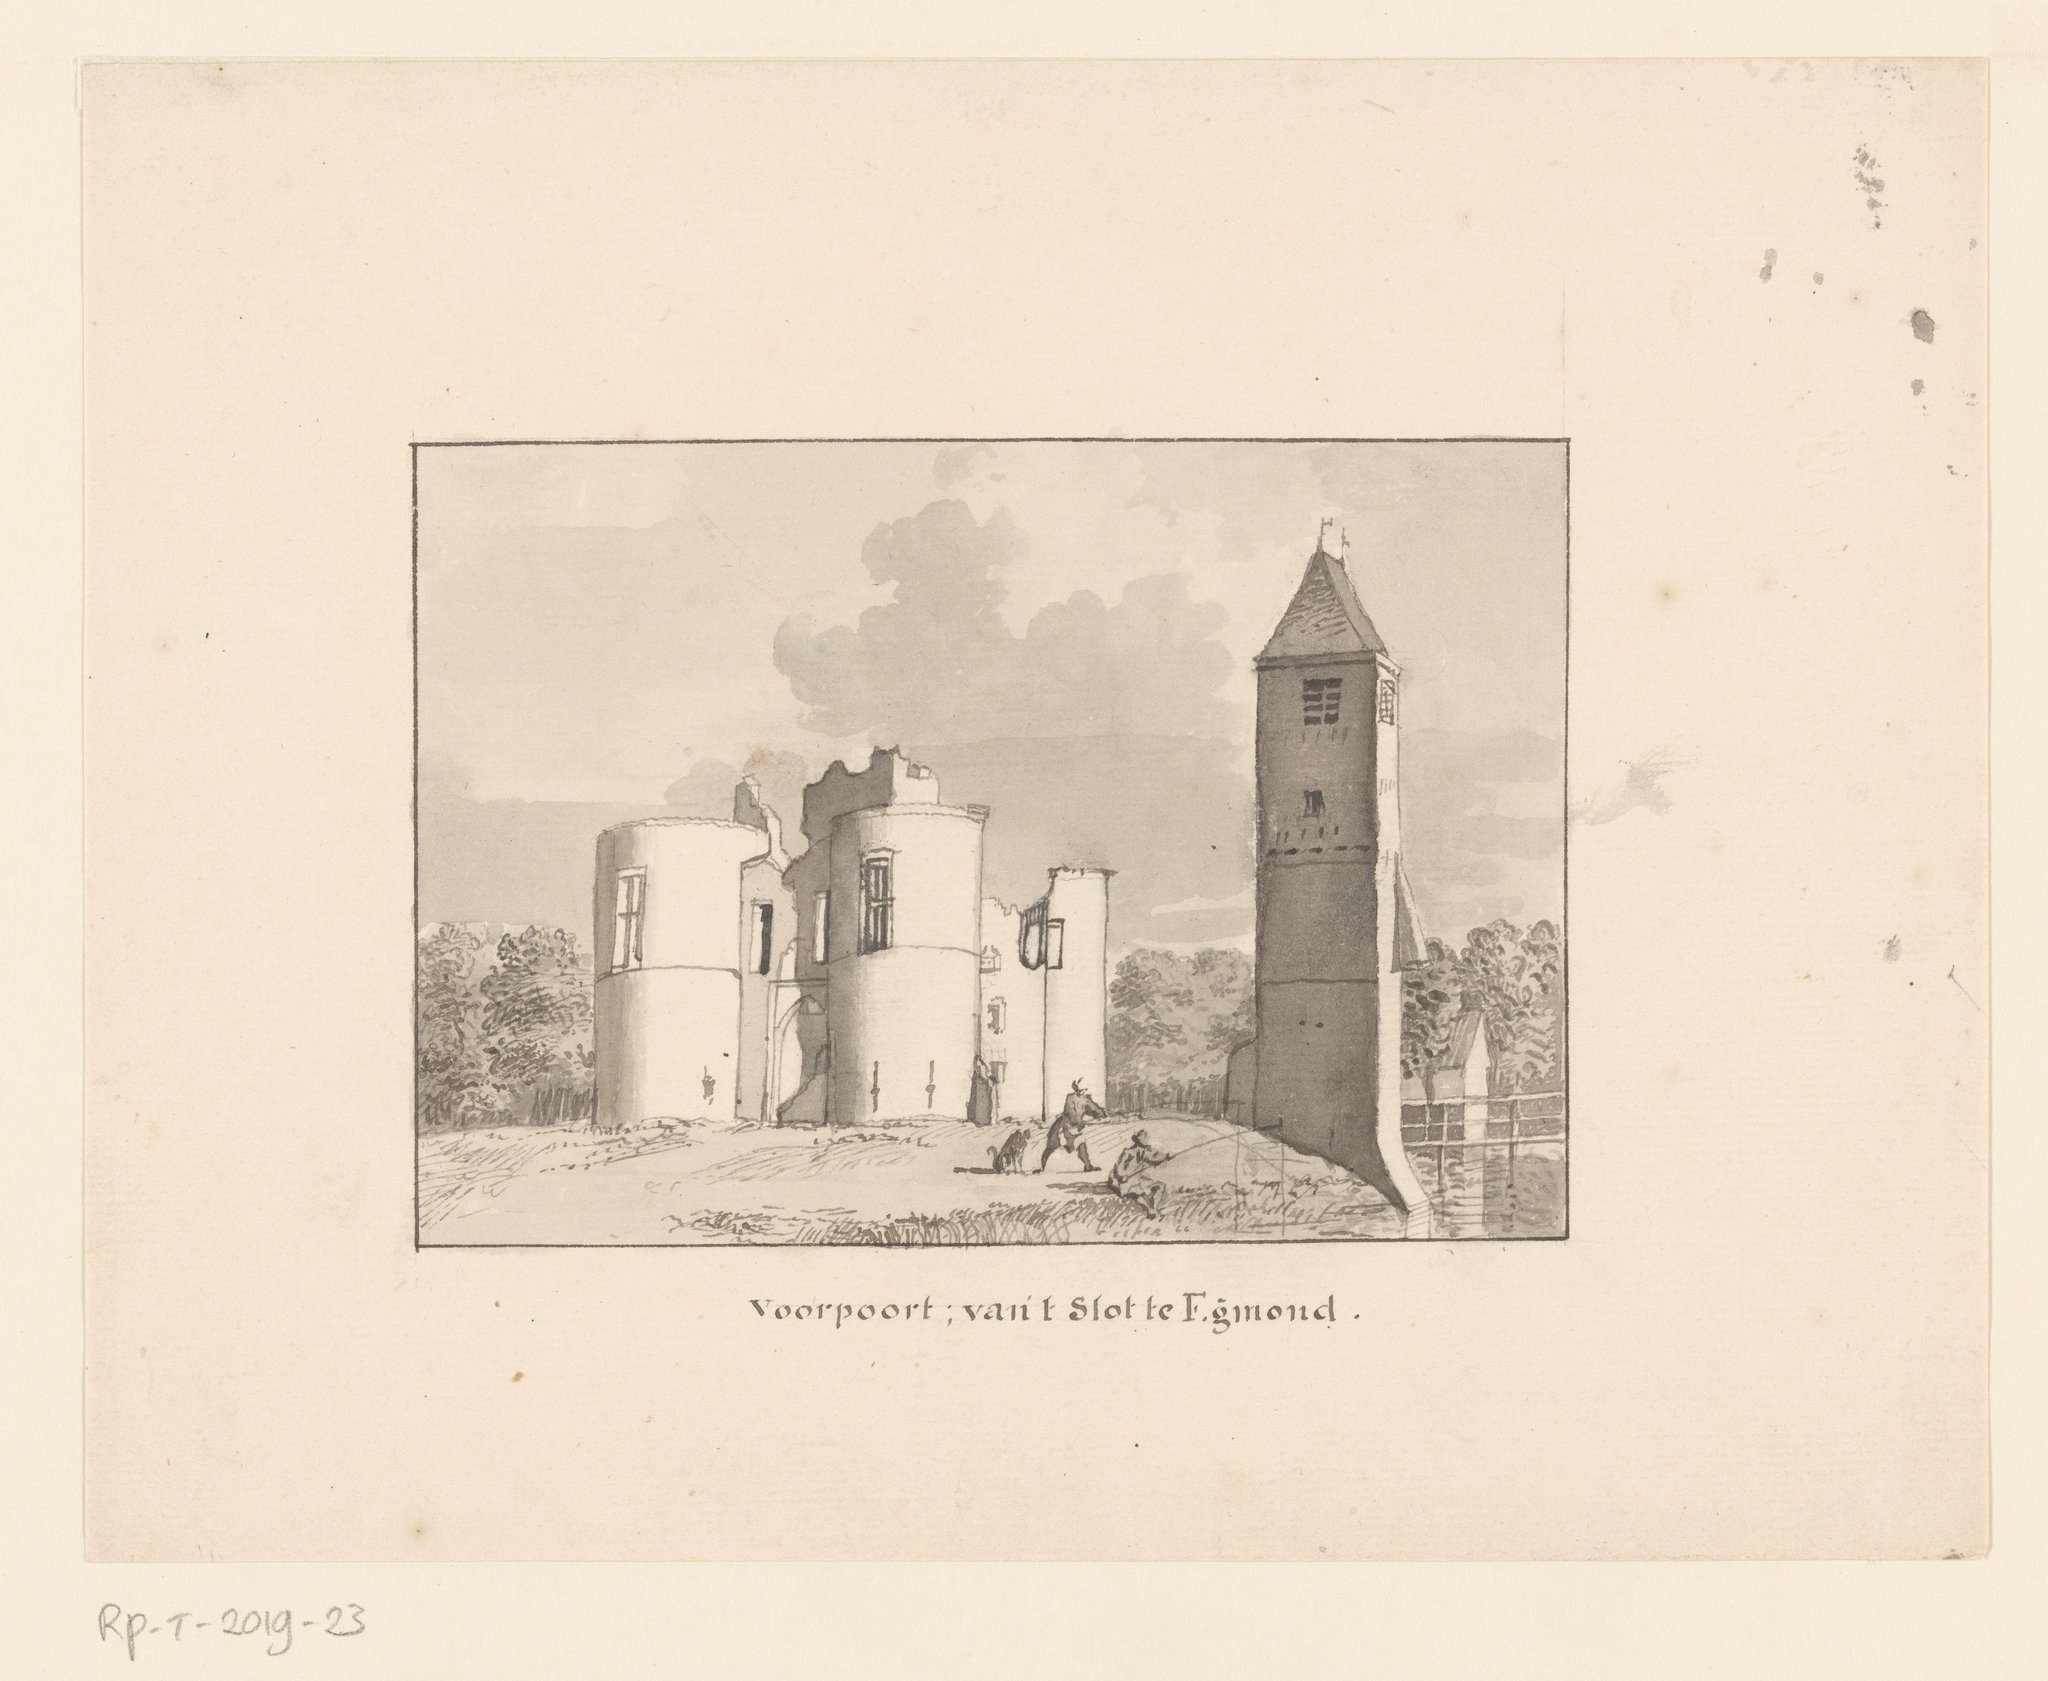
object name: drawing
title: Voorpoort; van 't Slot te Egmond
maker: a. kuys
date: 1969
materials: ink, paper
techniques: brush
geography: amersfoort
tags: landscape with ruins (+ city(-scape) with figures, staffage), ruin of a dwelling, house, castle, etc.